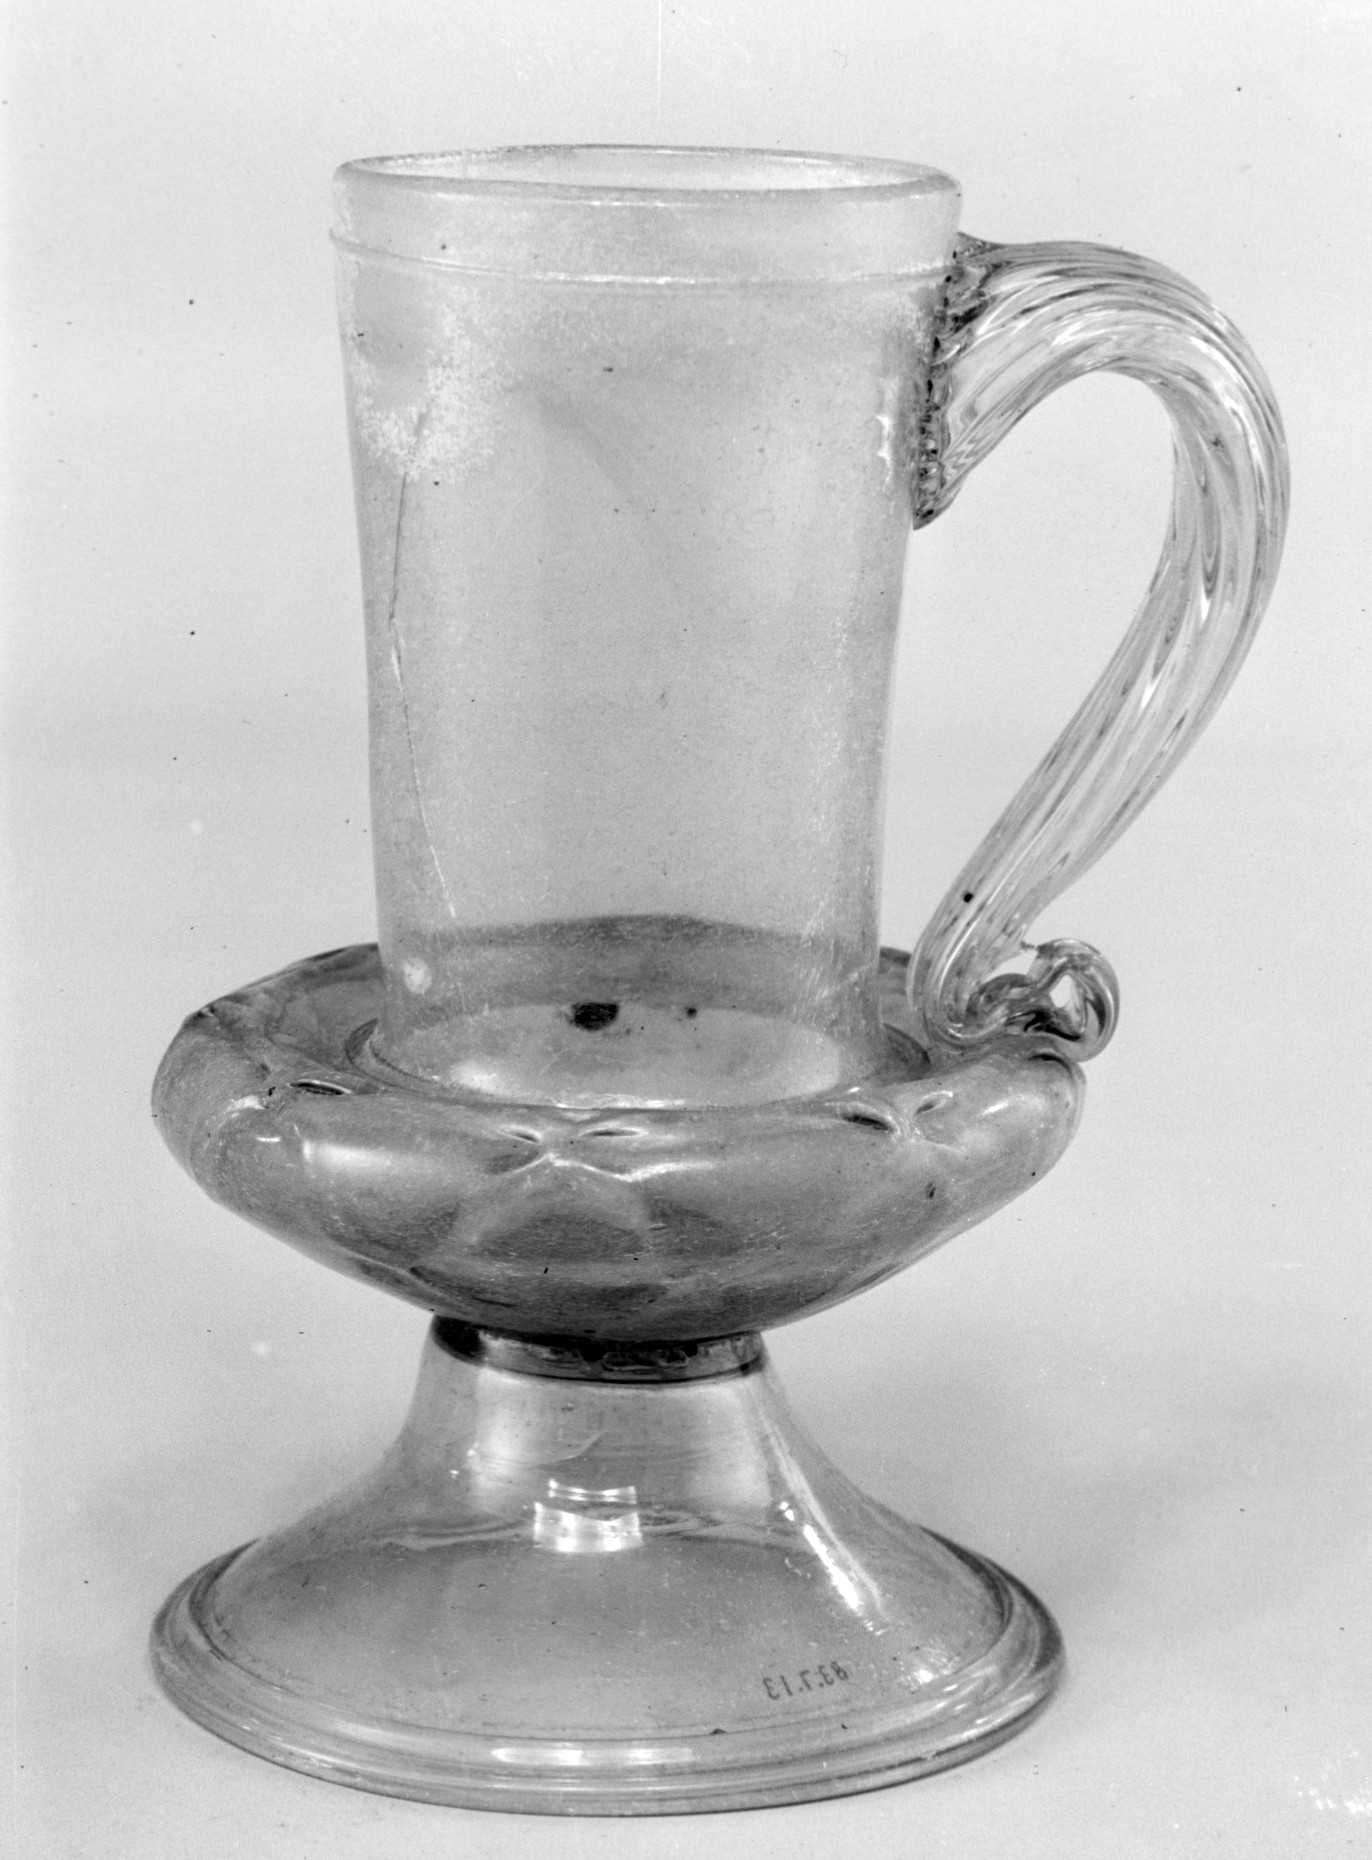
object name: jug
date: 1701-1800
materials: glass